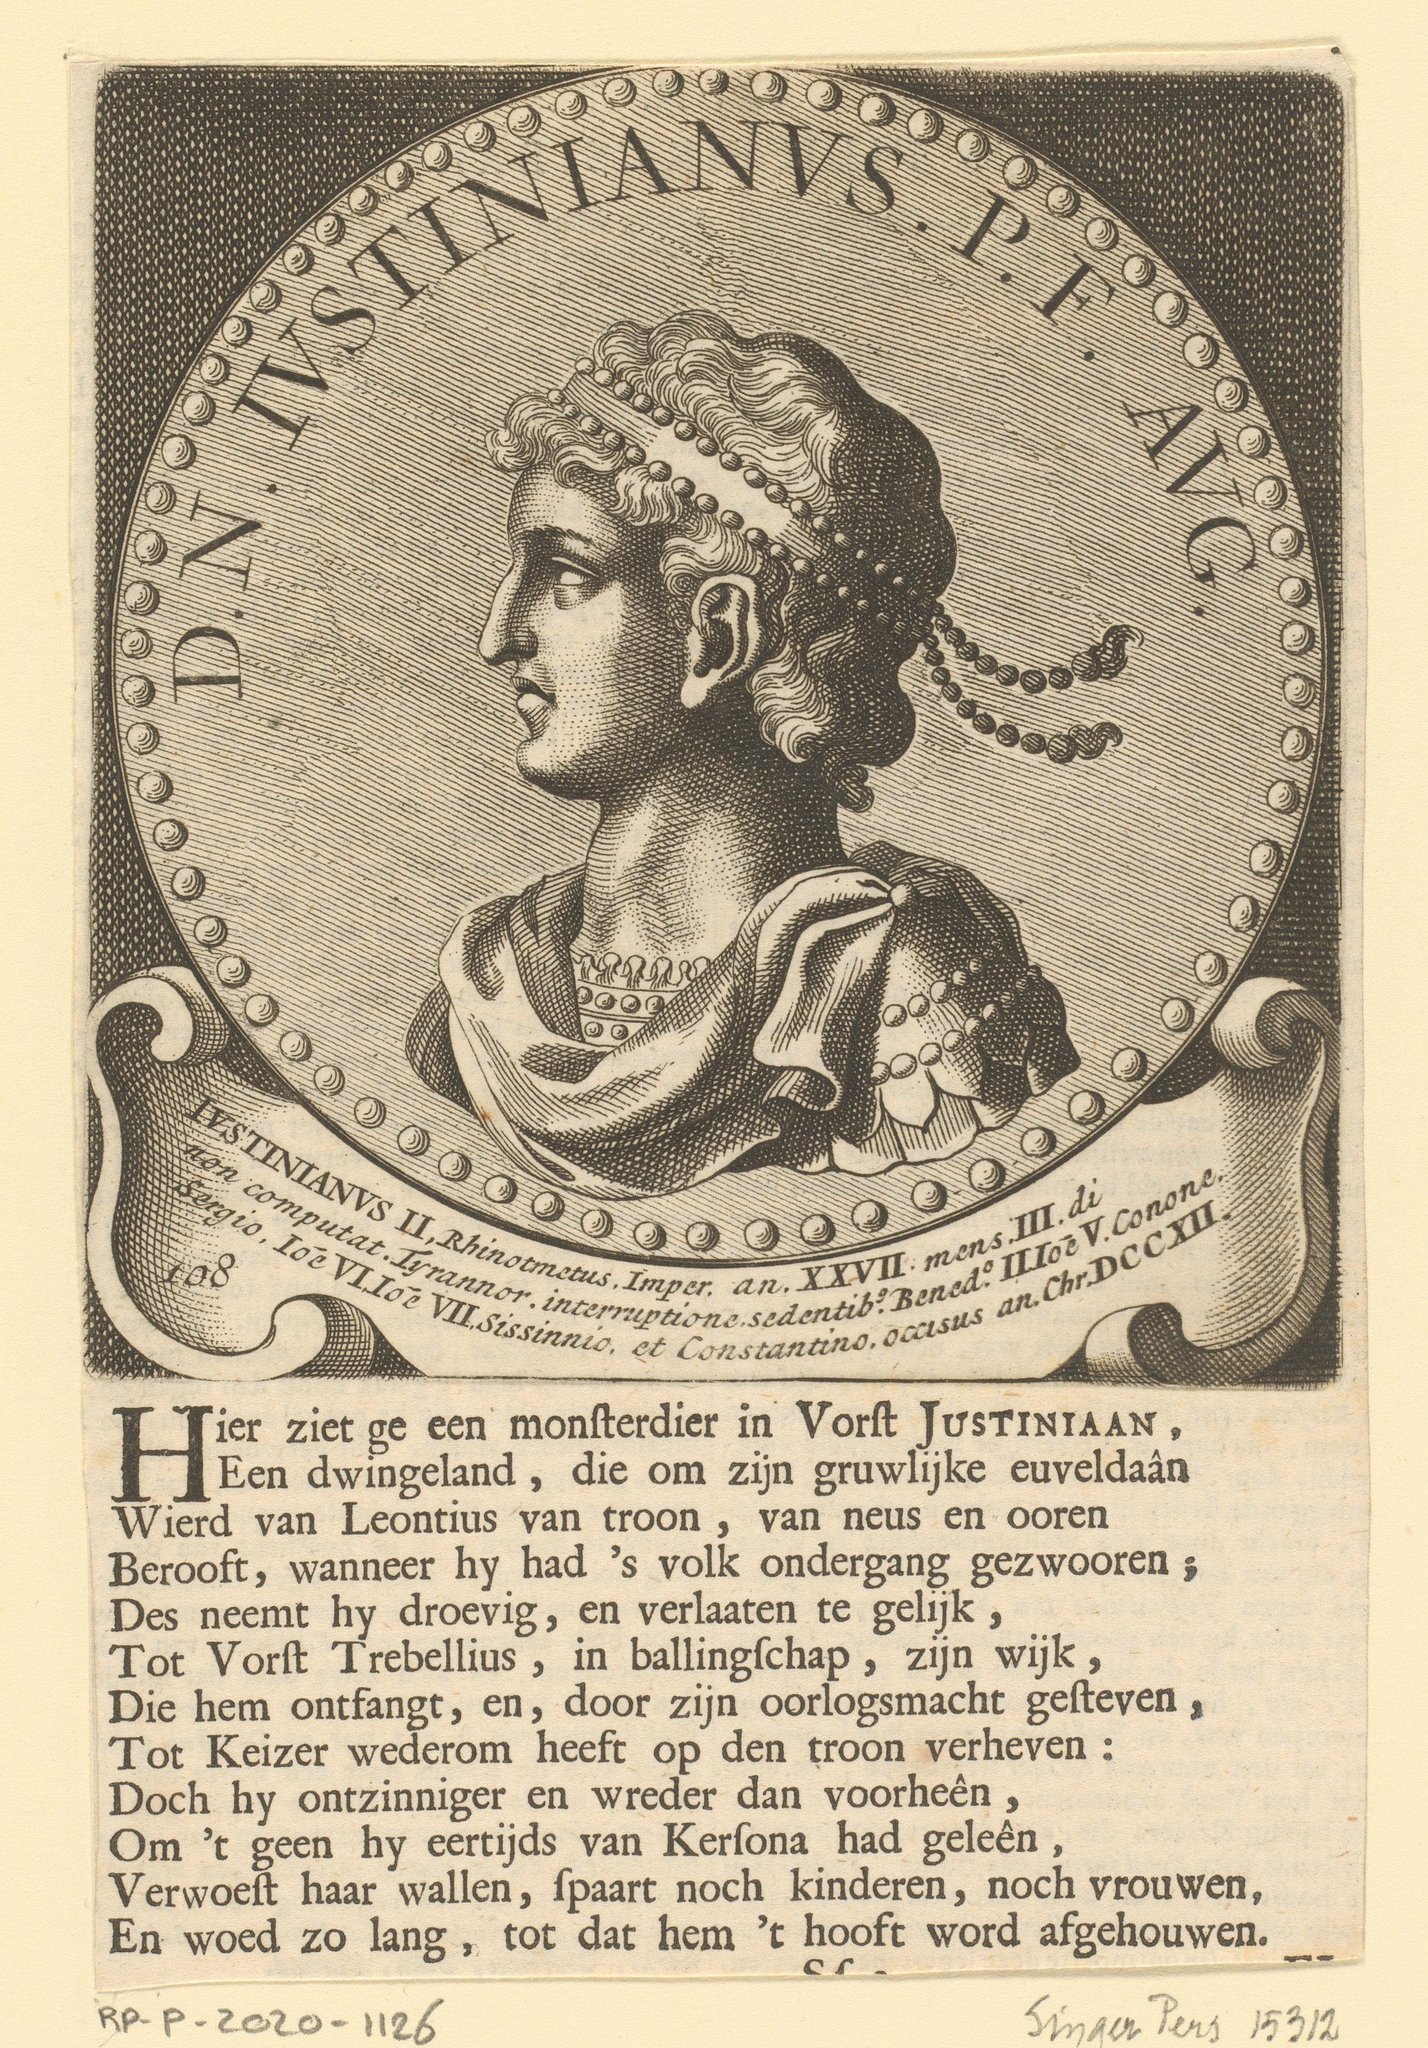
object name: print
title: Portret van keizer Justinianus II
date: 1697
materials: paper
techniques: engraving, etching, letterpress printing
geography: utrecht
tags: historical persons, emperor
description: Prent uit: Bogaert, Abraham. De Roomsche monarchy, vertoont in de muntbeelden der westersche en oostersche keizeren (...). Utrecht: François Halma en Willem van de Water, 1697, p. 323. Eerste staat verschenen in een grotere prent met twaalf portretten, gedateerd 1695.